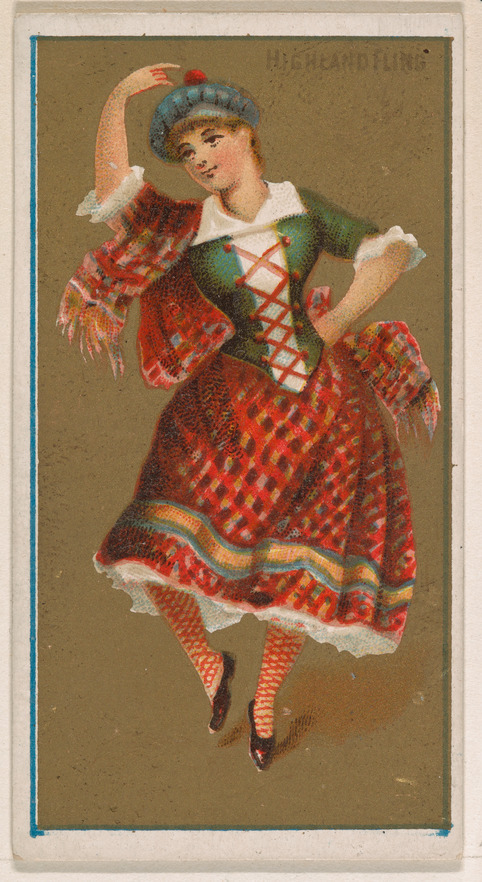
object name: print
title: Highland Fling, from National Dances (N225, Type 1) issued by Kinney Bros.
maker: kinney brothers tobacco company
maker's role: publisher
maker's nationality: american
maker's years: 1869-2011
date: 1889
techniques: color lithograph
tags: women,dancing,dancers